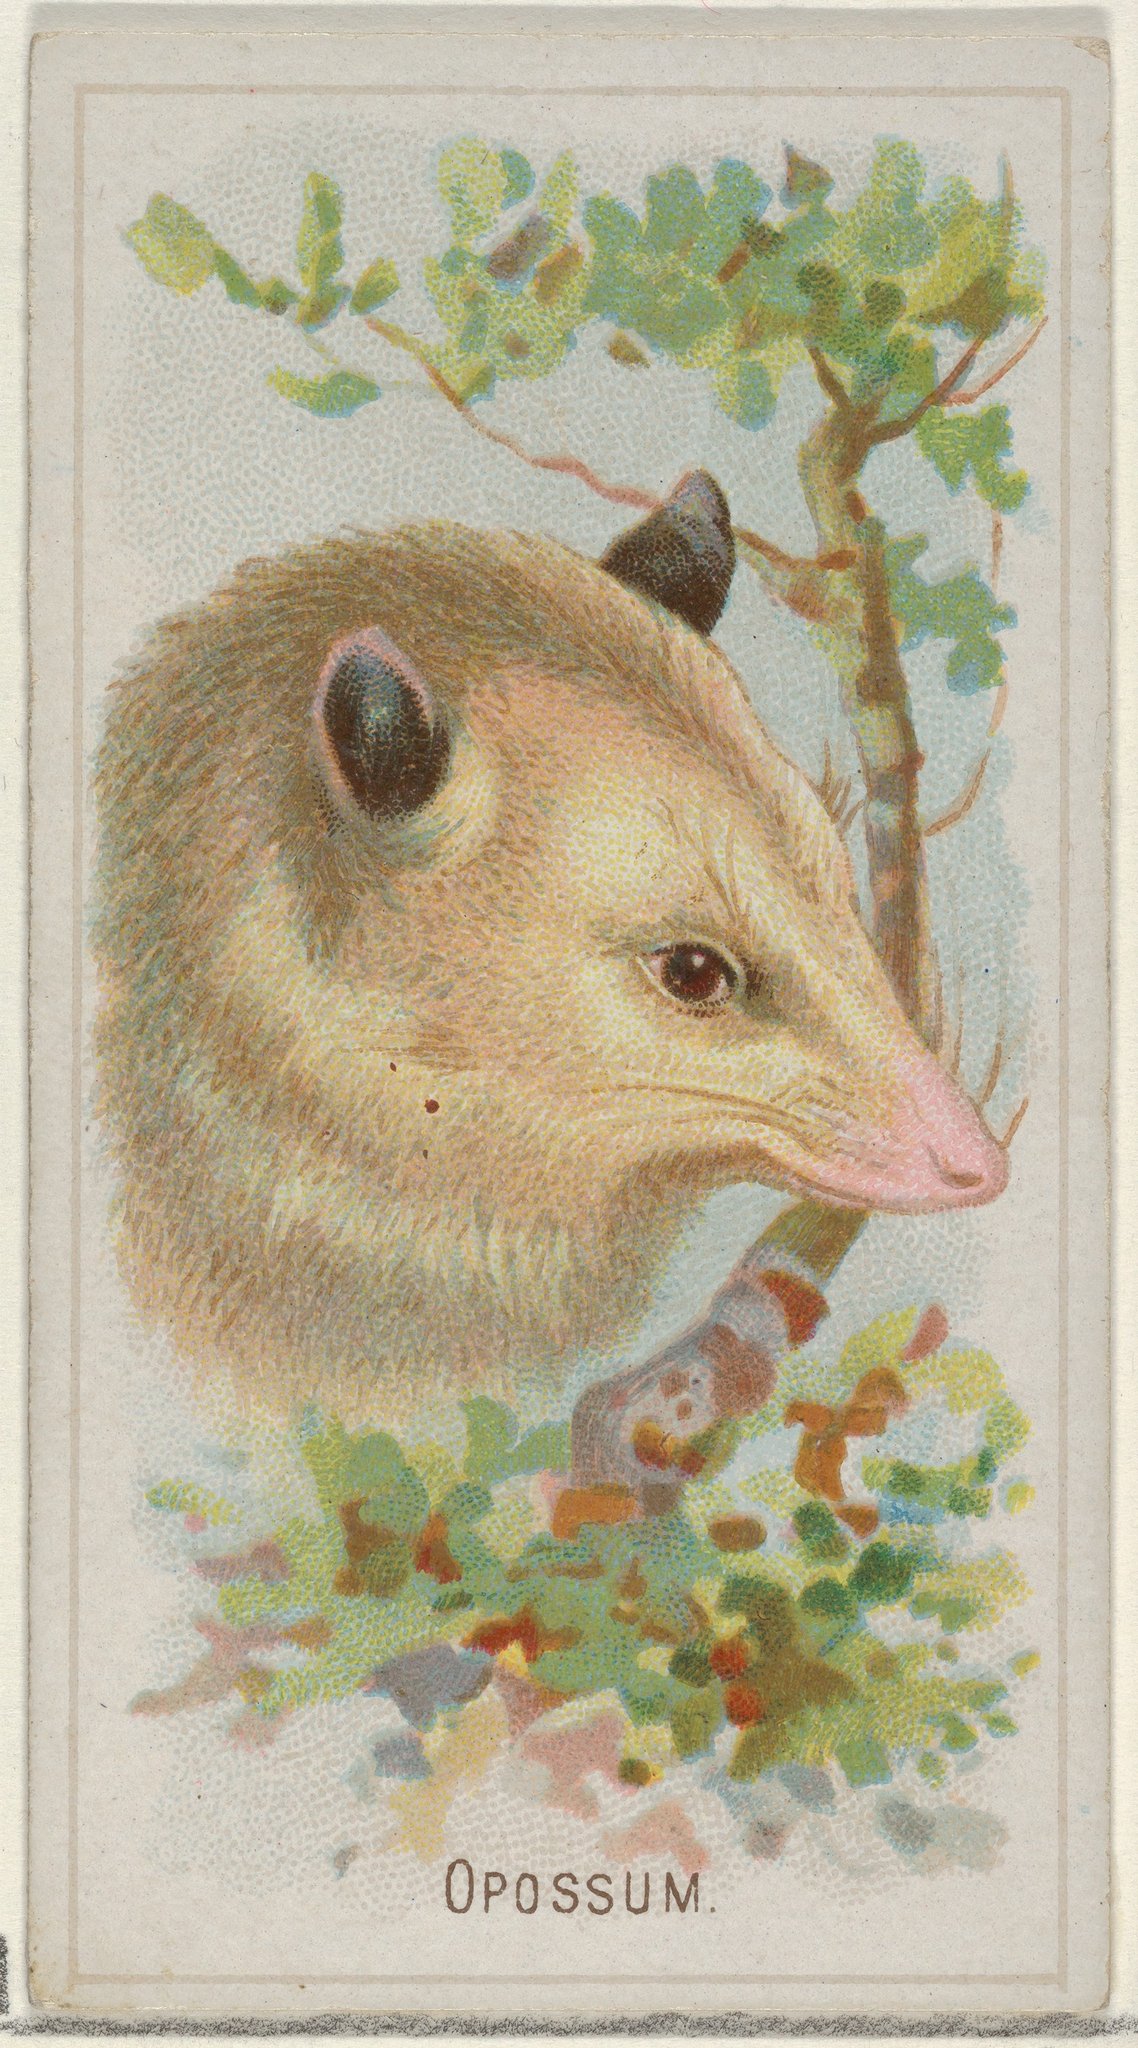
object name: print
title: Opossum, from the Wild Animals of the World series (N25) for Allen & Ginter Cigarettes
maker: allen & ginter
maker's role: publisher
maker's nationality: american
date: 1888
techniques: color lithograph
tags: animals